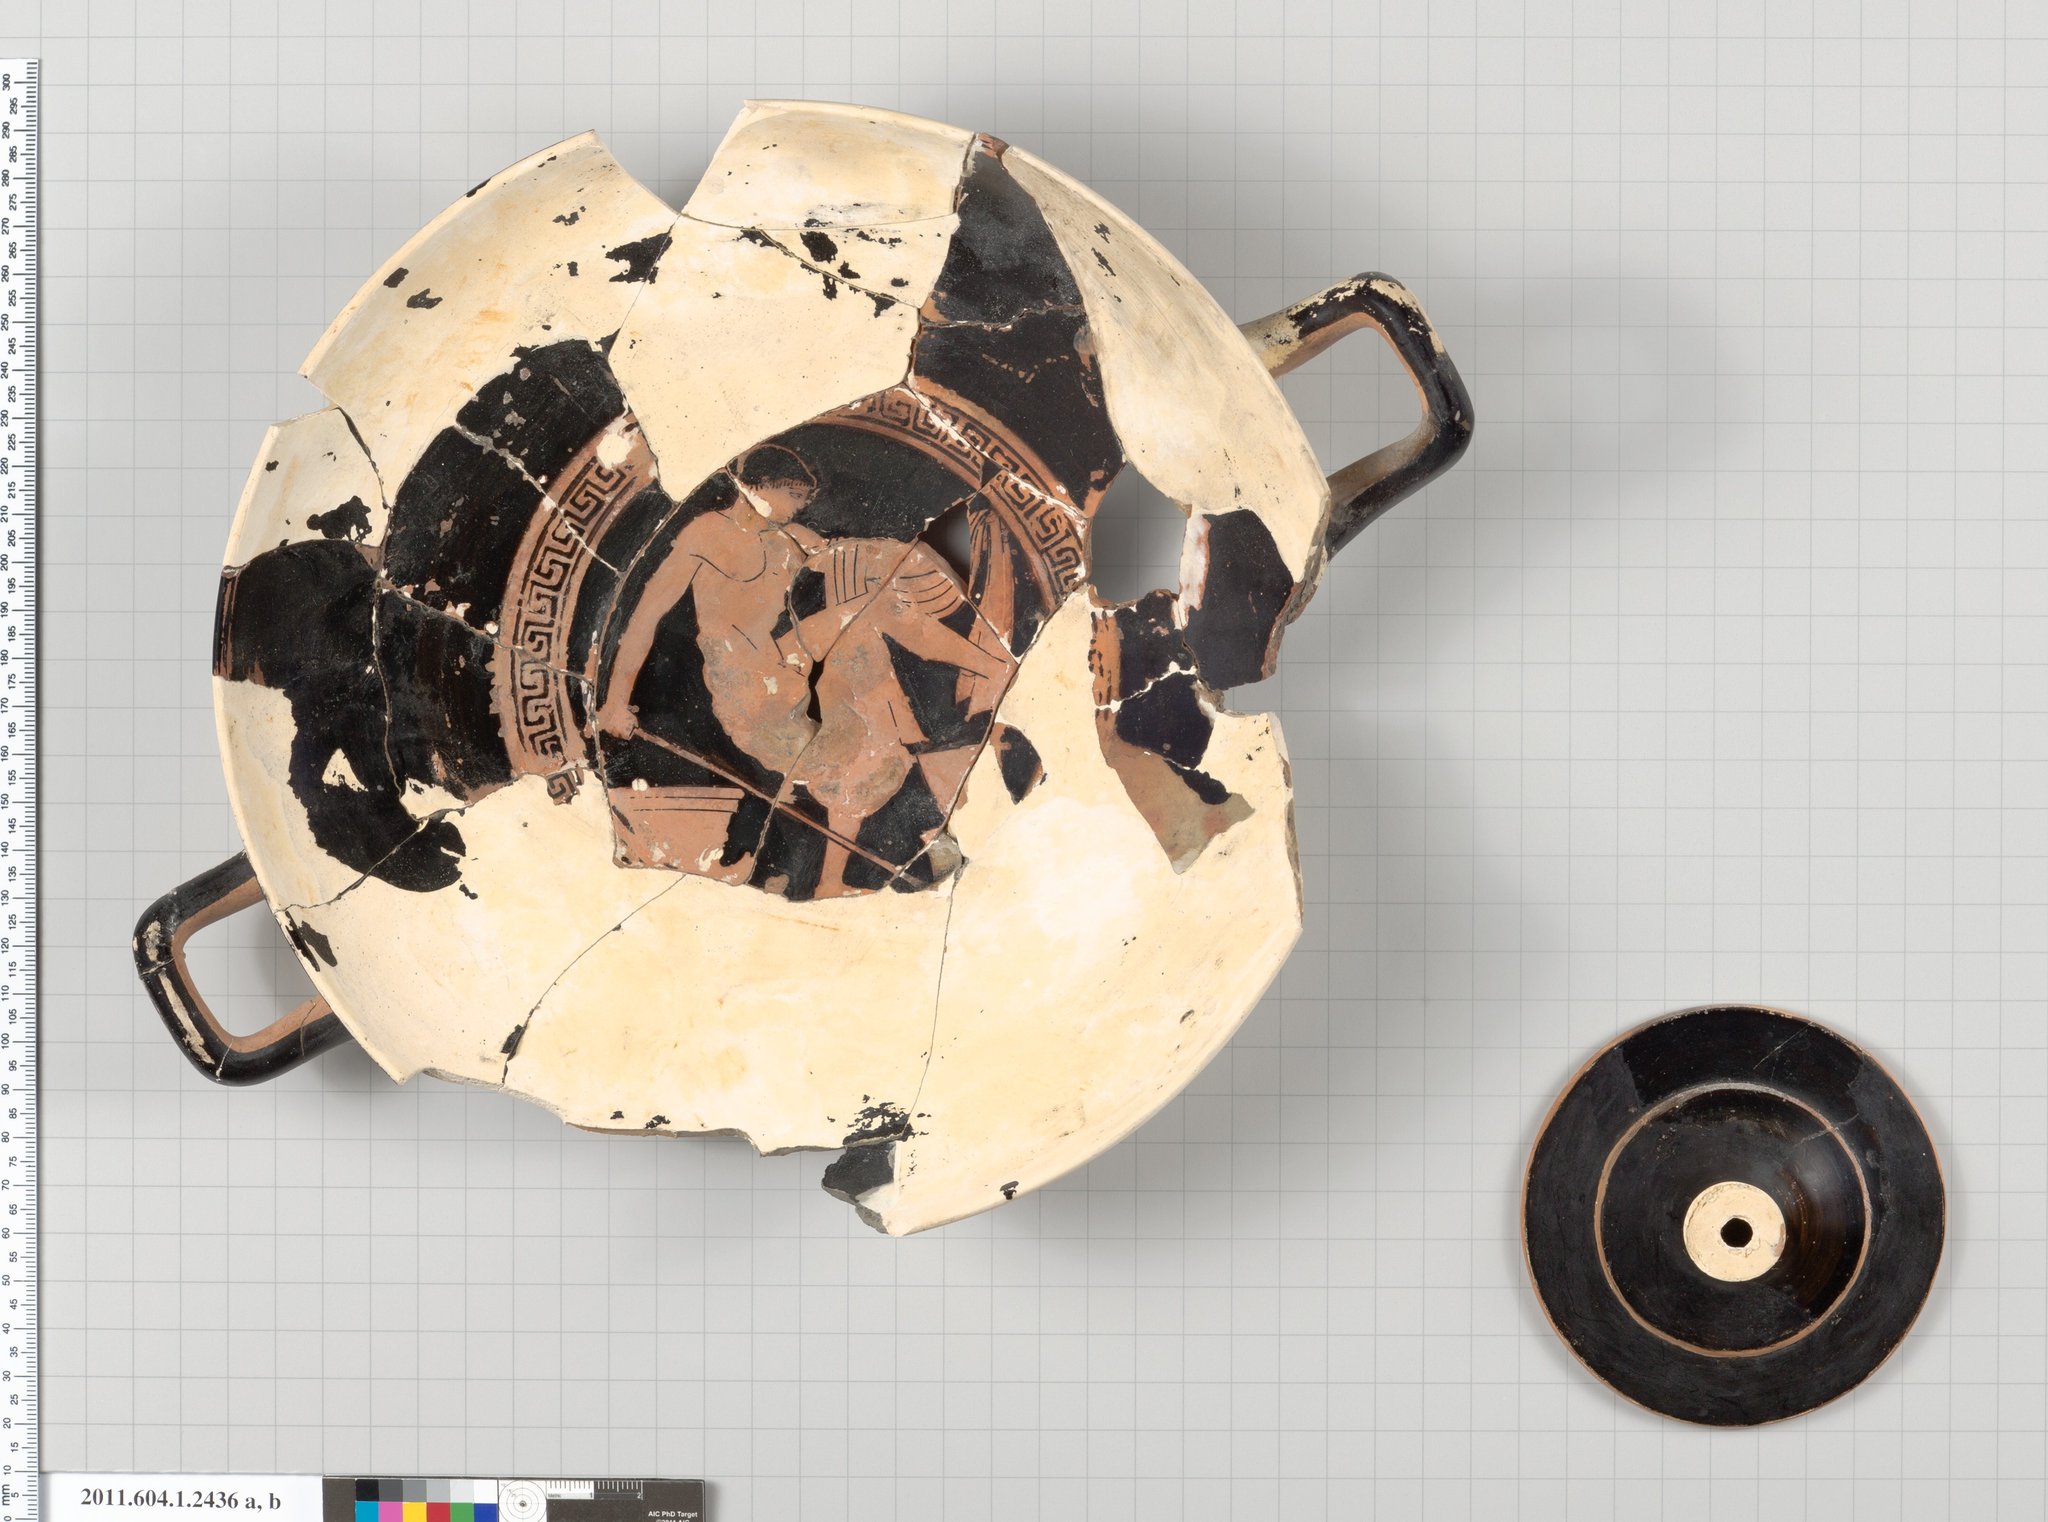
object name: kylix fragment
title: Terracotta fragments of a kylix (drinking cup)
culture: greek, attic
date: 500-480 BCE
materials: terracotta